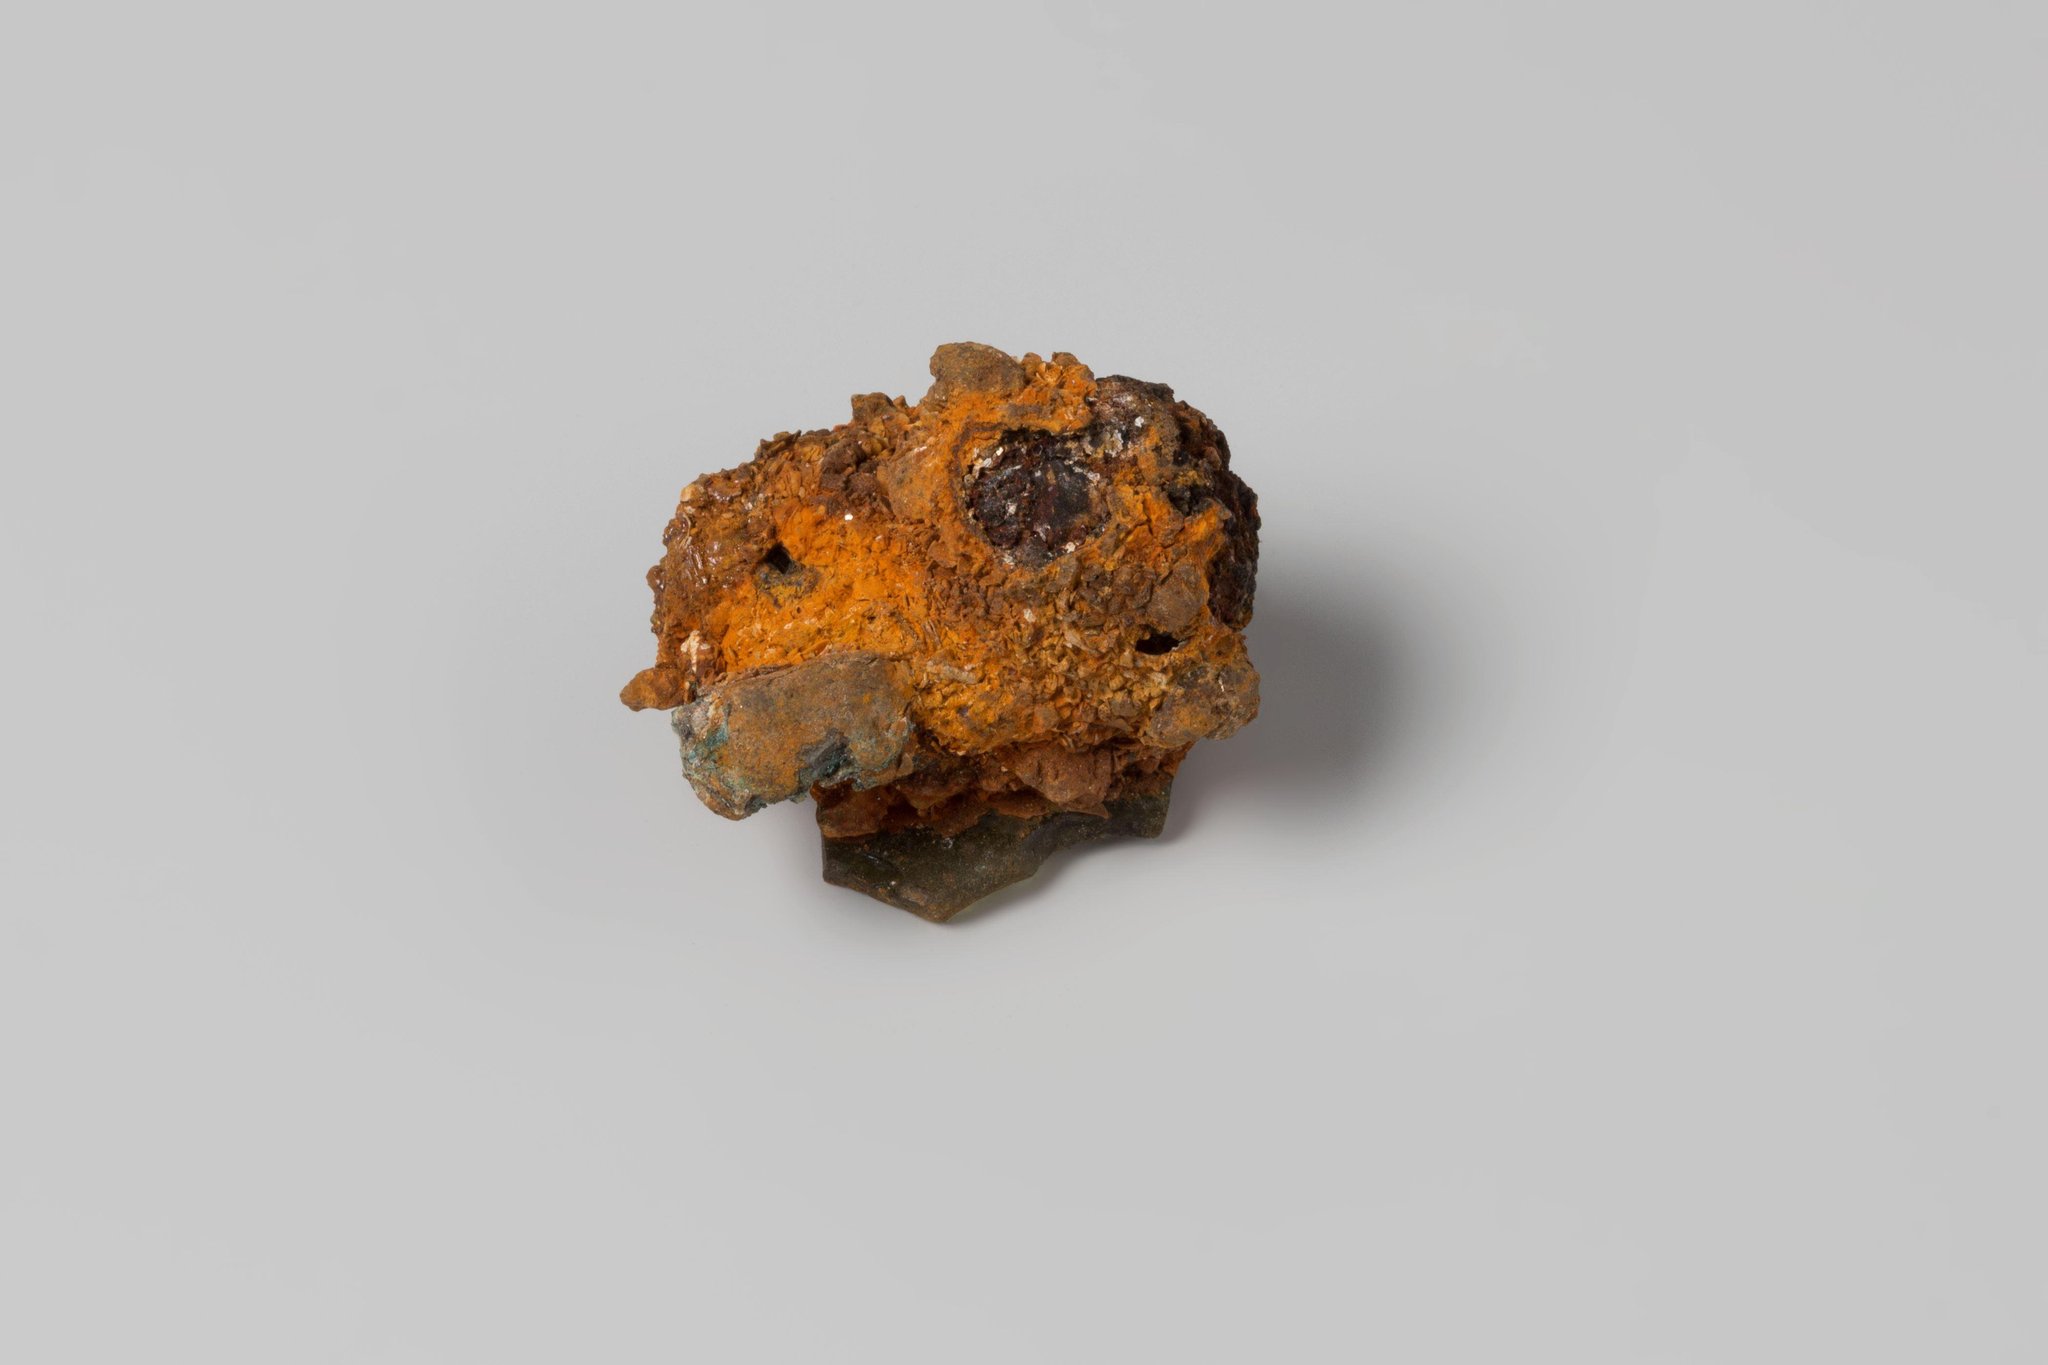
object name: concretionary stone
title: Concretie met glasfragmenten uit het wrak van de Oost-Indiëvaarder Hollandia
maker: Anonymous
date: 1700-1743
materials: stone, glass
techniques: green glass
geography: netherlands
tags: verenigde oostindische compagnie, hollandia (schip), annet